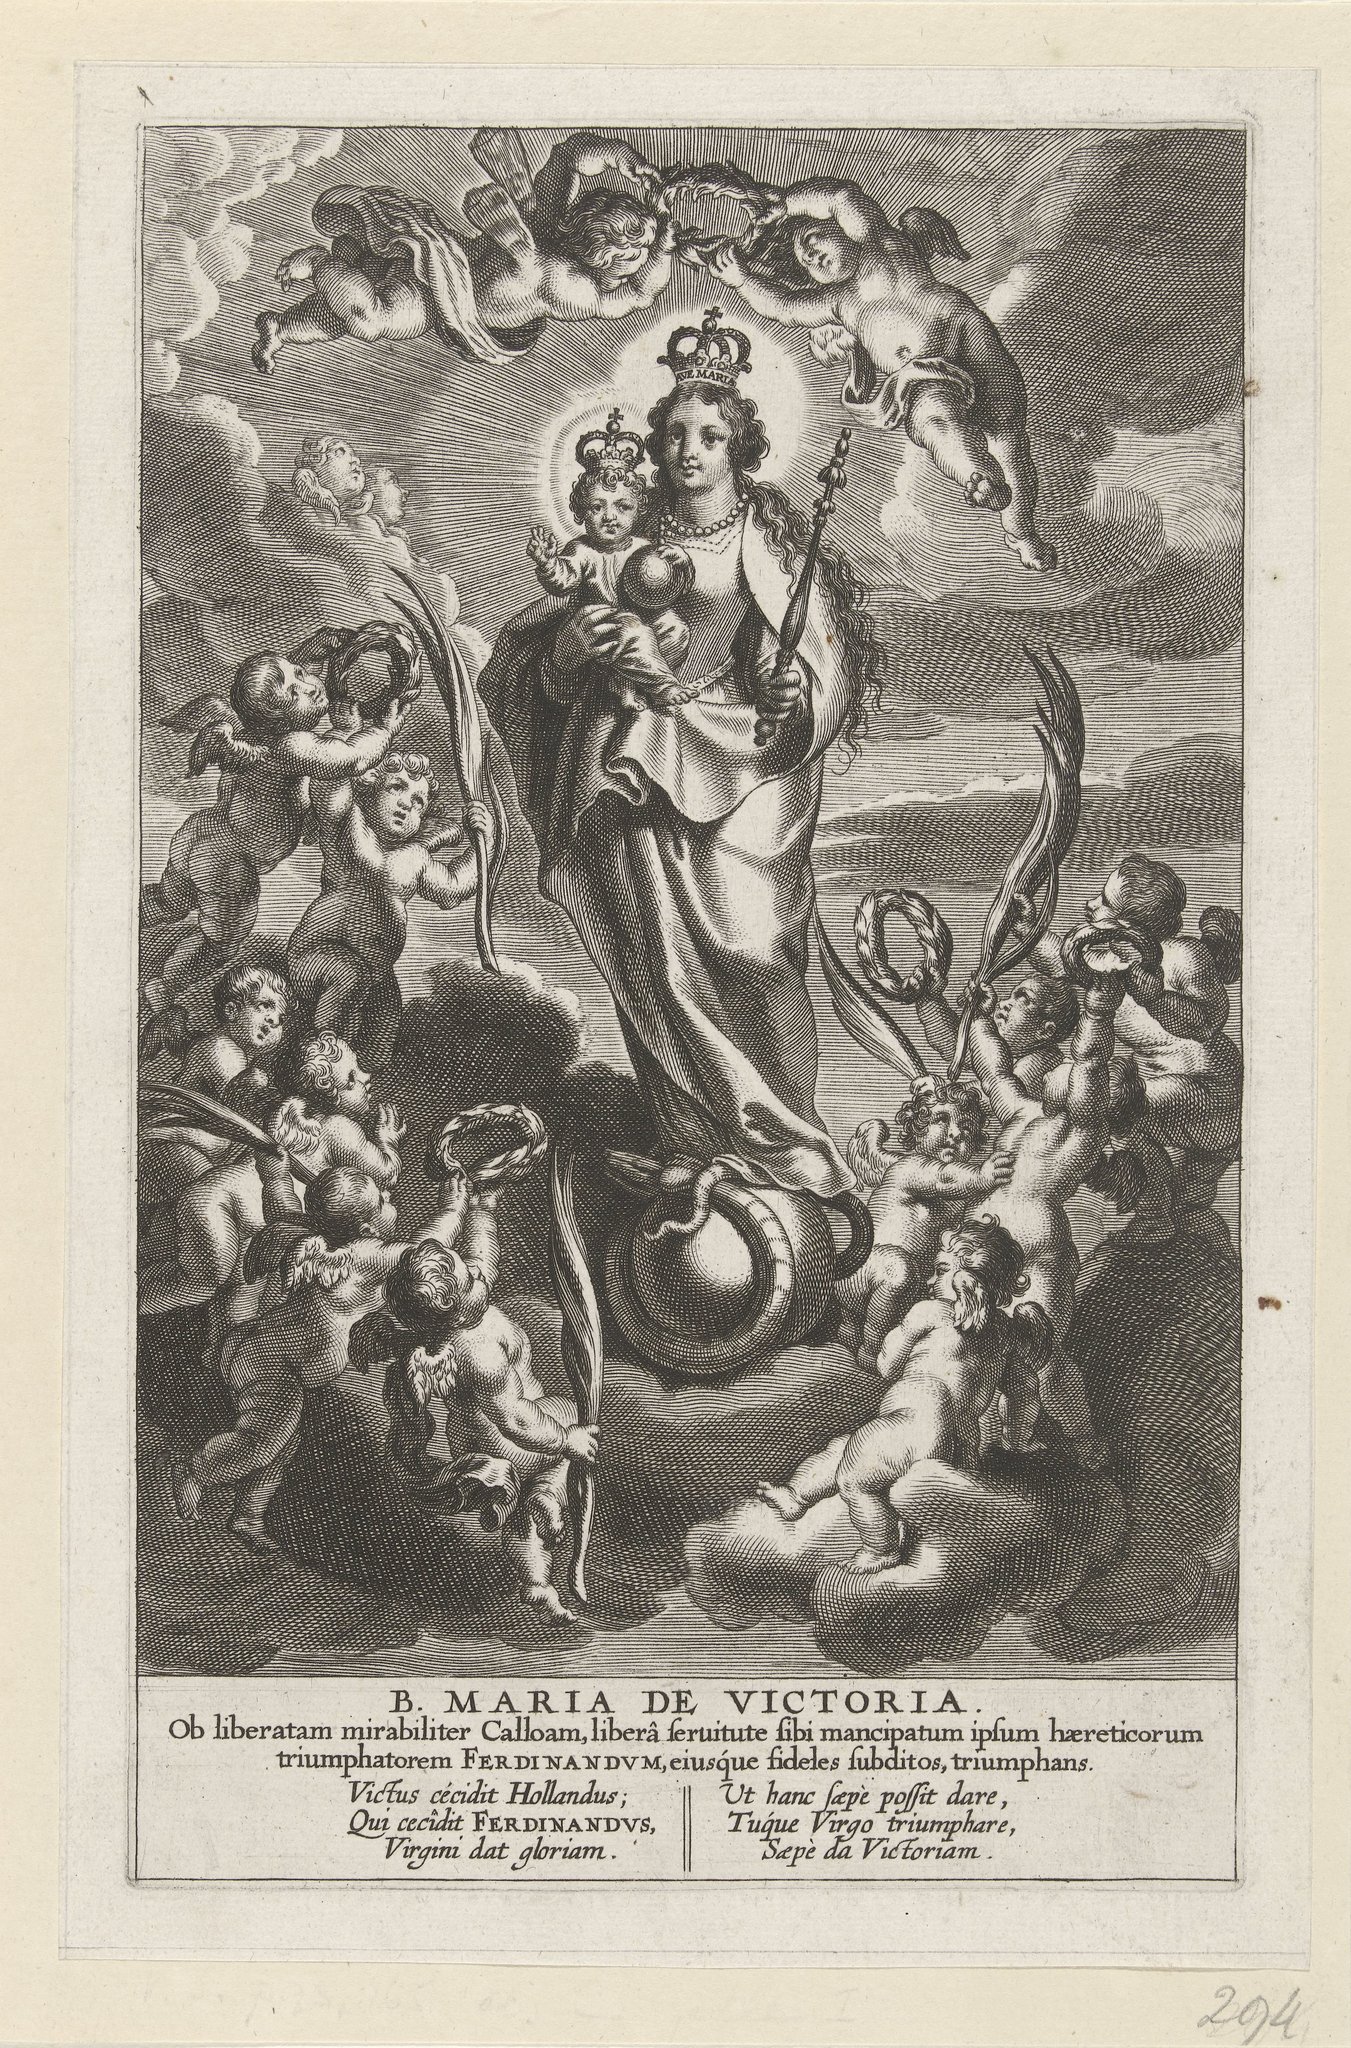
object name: print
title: Staande Maria's met Kind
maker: cornelis galle (i)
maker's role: print maker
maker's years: 1576-1650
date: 1586-1650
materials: paper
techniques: engraving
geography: southern netherlands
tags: specific types of standing (or half-length) madonna's, without others, mary standing or resting on the earth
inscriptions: collector's mark: Lugt 240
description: Gekroonde Maria met Kind op haar arm, een scepter in haar hand. Maria staat op een globe en vertrapt met haar voet een slang. Omringd door engelen met palmtakken en lauwerkransen. Onder de voorstelling een Latijnse tekst, en een vers in twee coupletten.